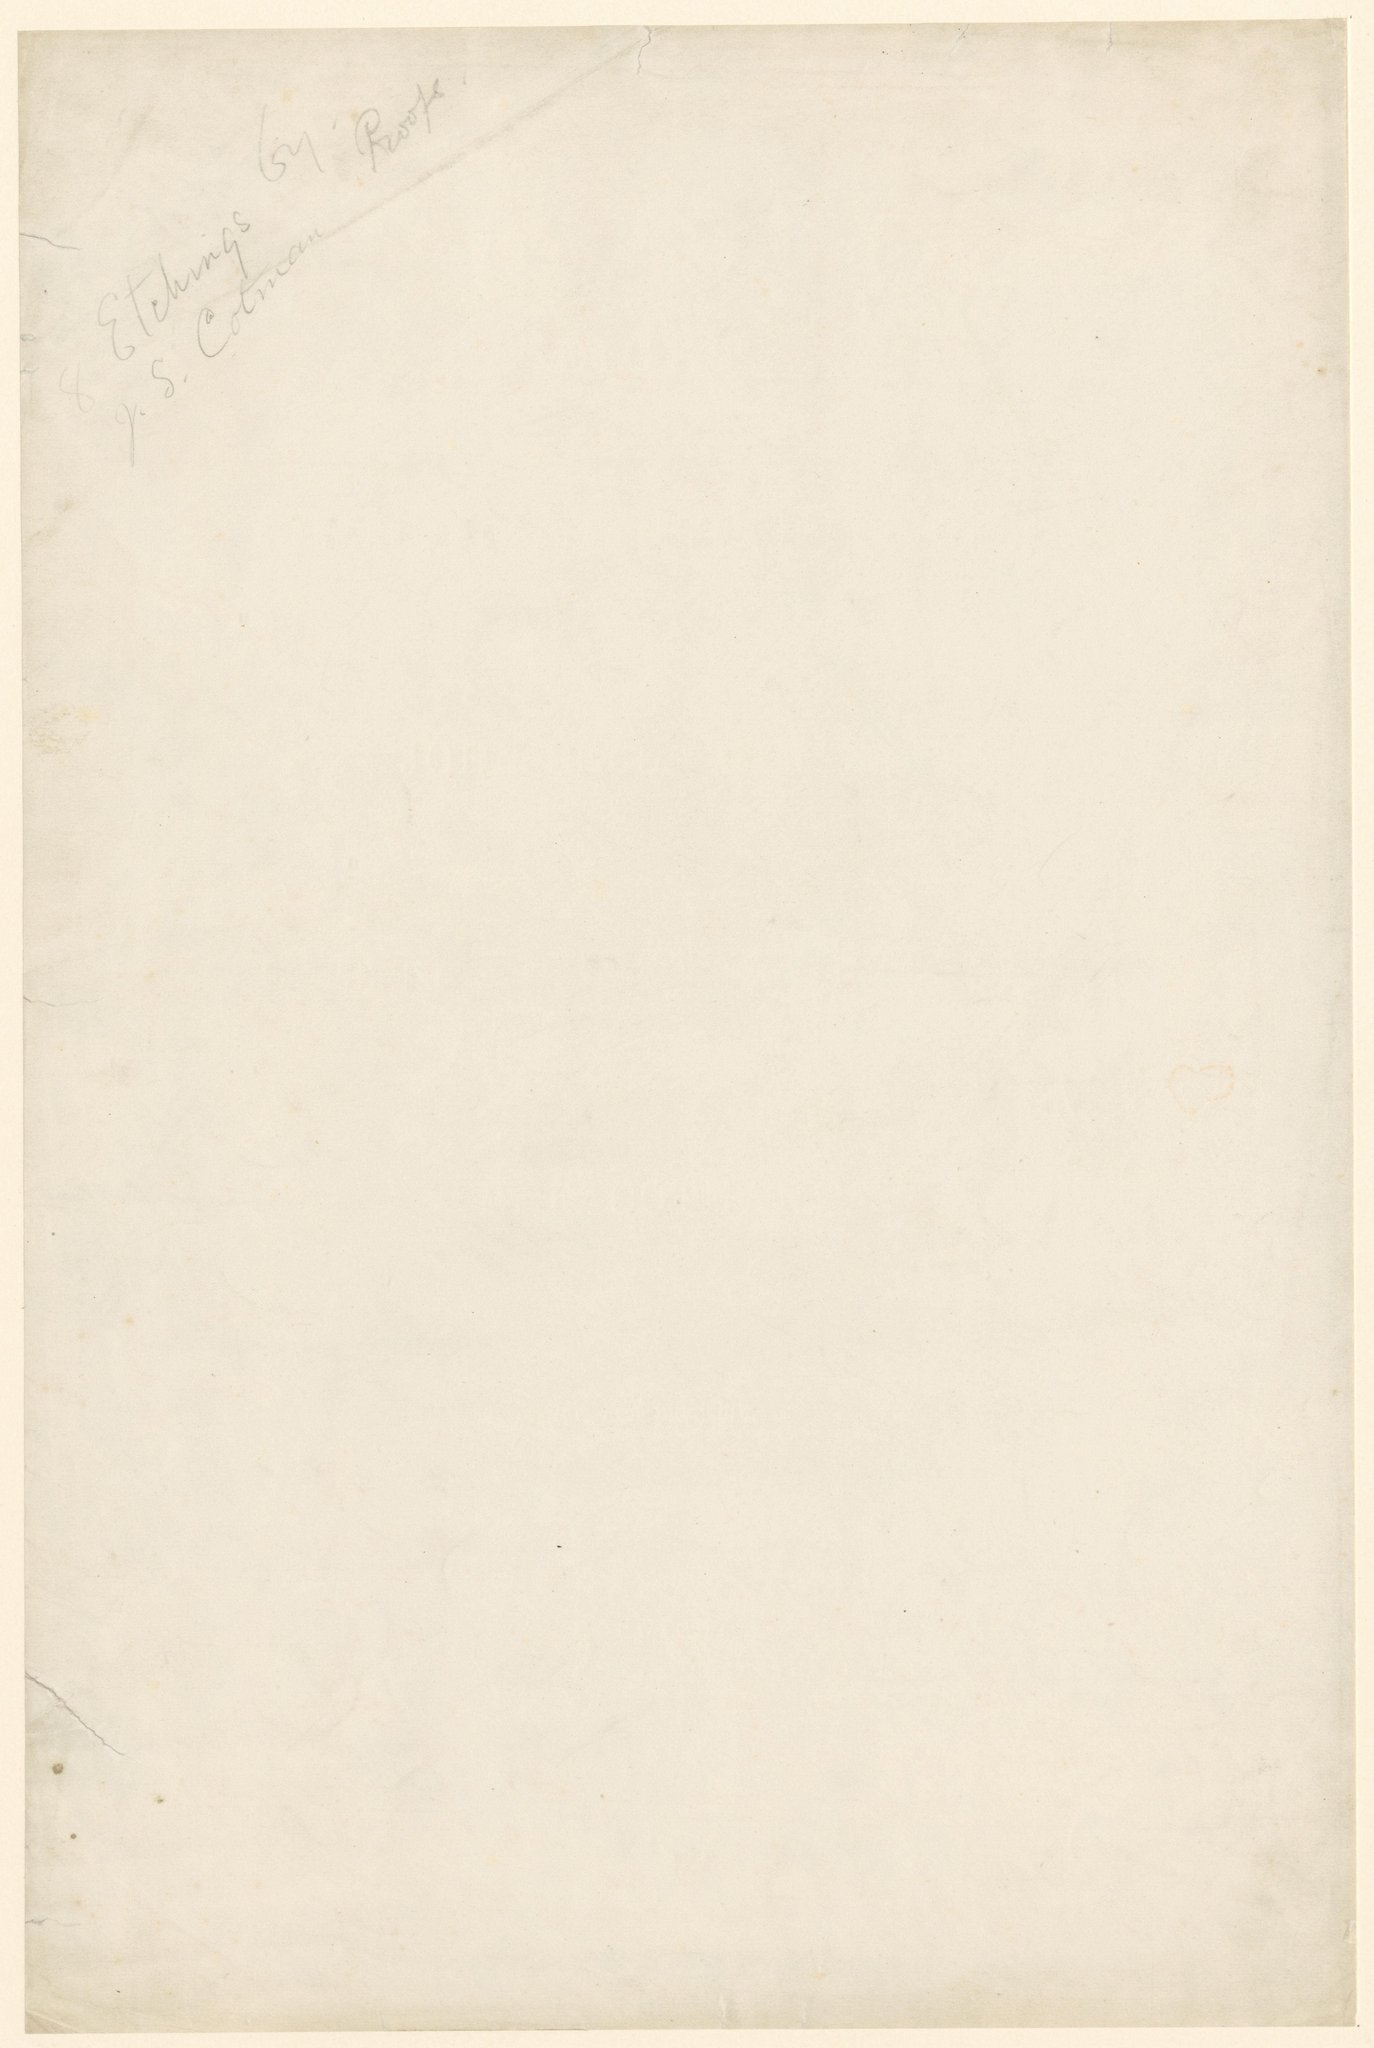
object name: titelprent, frontispice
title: Acht originele etsen door wijlen John Sell Cotman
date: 1846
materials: paper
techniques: blind stamped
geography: norwich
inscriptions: collector's mark: Lugt 2760, collector's mark: Lugt 2228